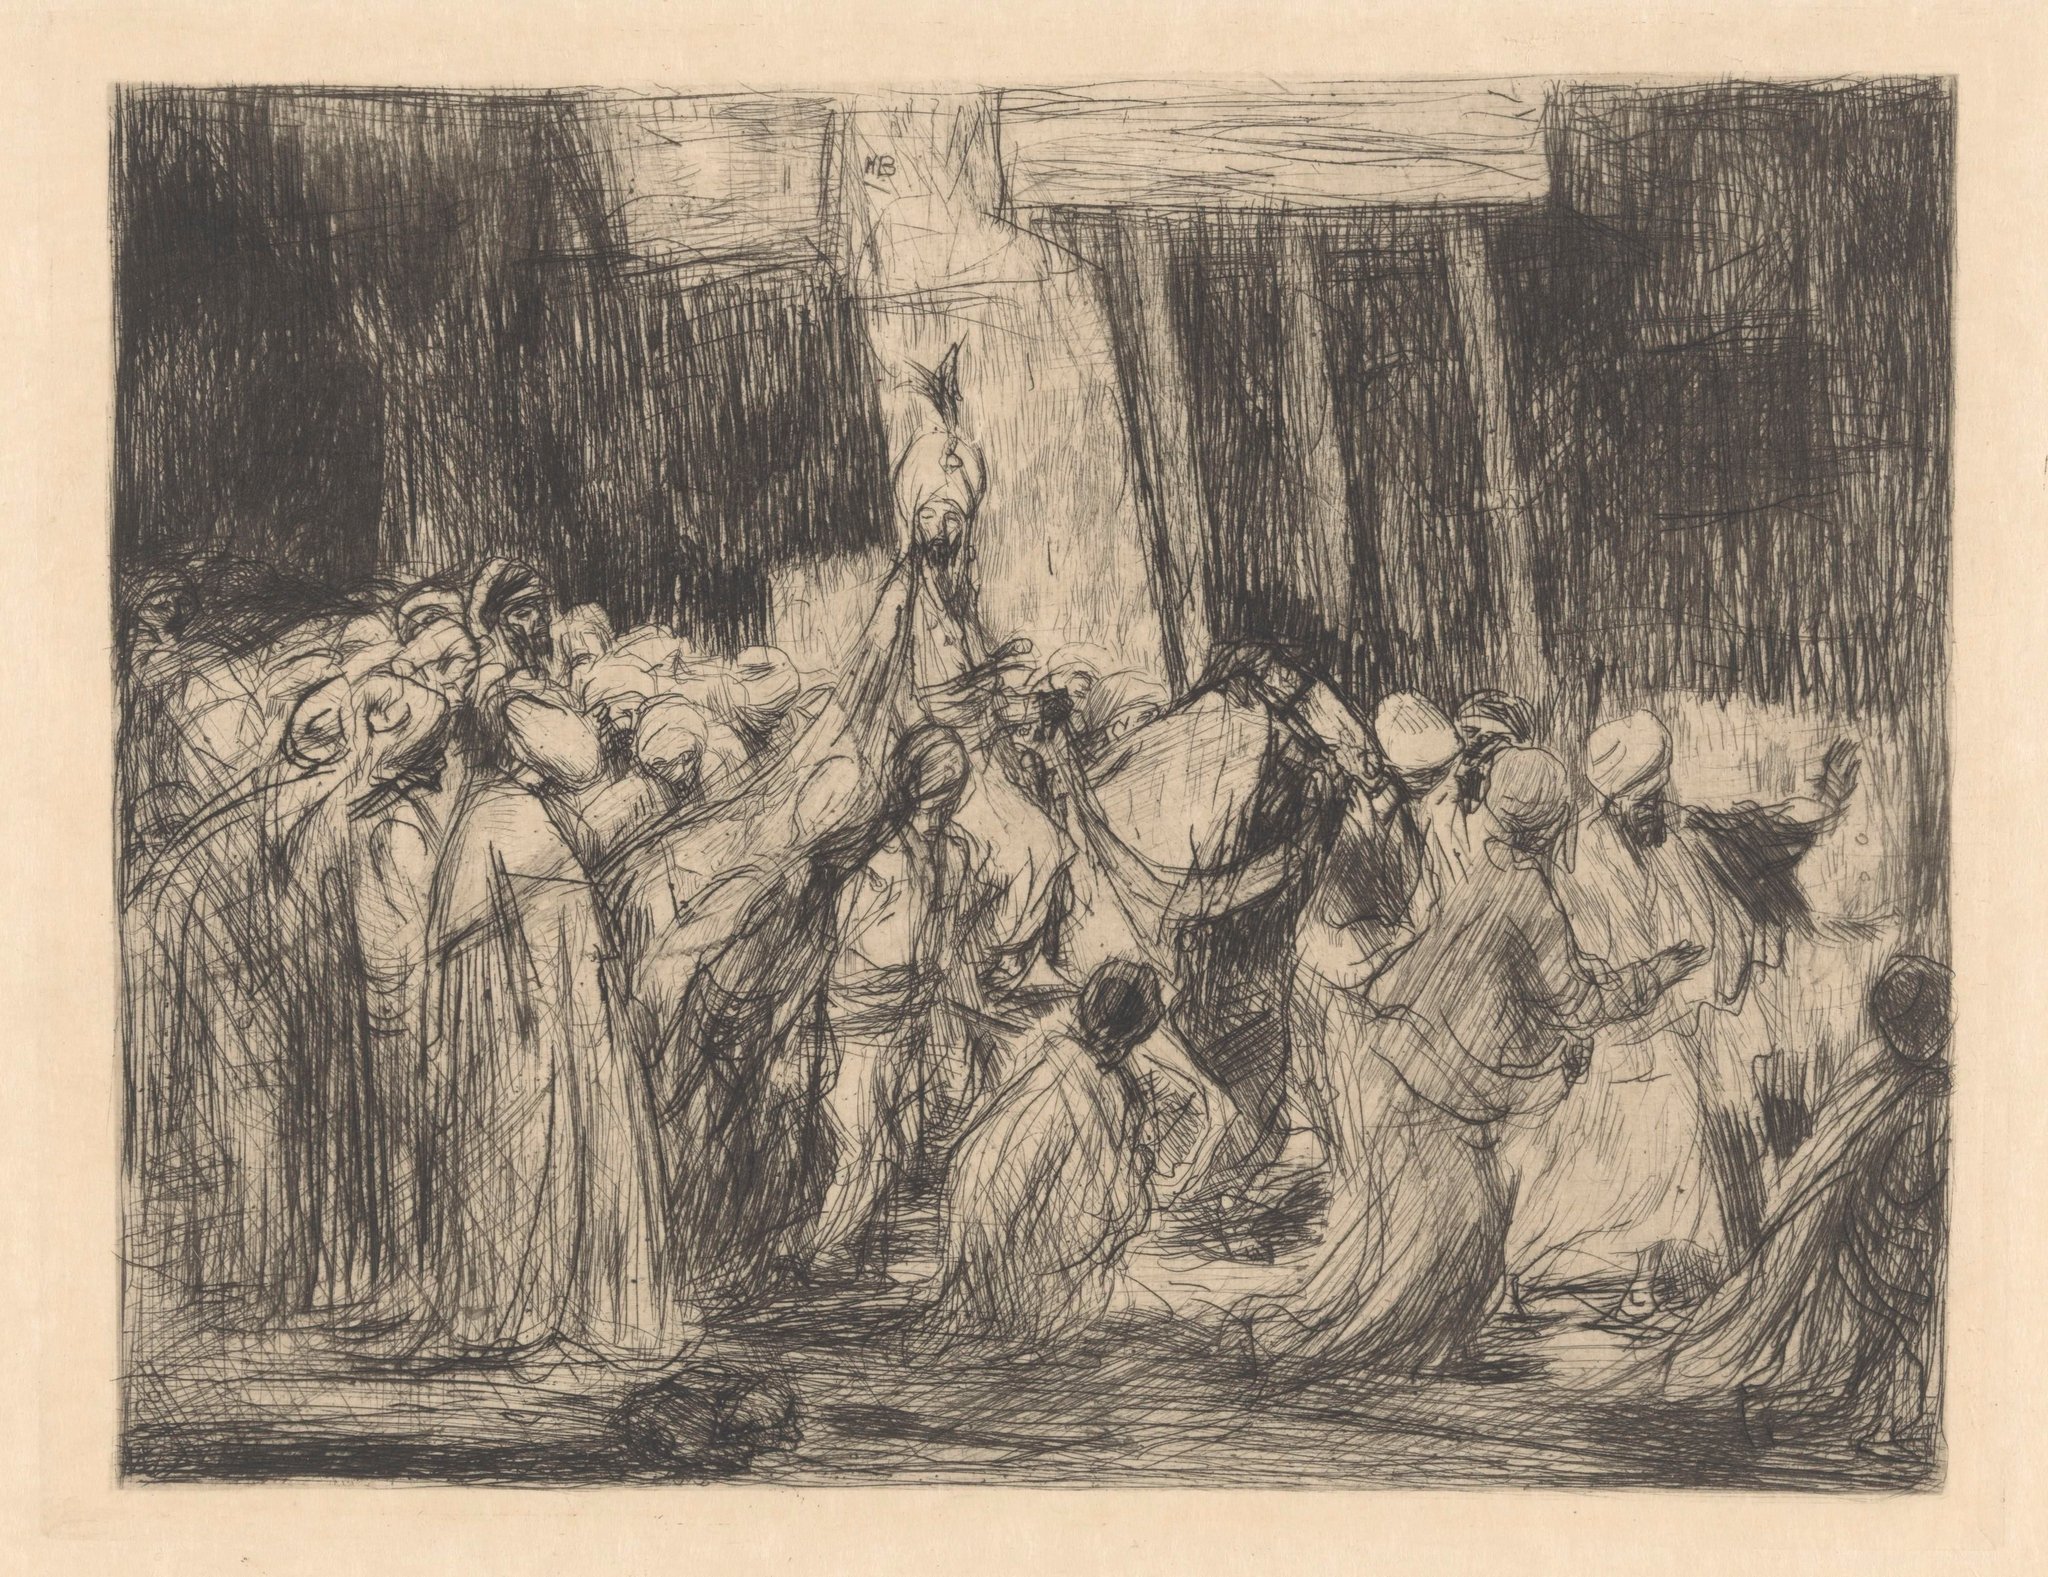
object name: print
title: Vizier op een paard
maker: marius bauer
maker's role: draughtsman, print maker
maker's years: 1867-1932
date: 1894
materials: paper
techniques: etching, intaglio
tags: official; civil servant; functionary (in general), head-gear: turban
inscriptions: collector's mark: Lugt 2228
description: Een vizier rijdt op een paard tussen een menigte mensen in een stad.